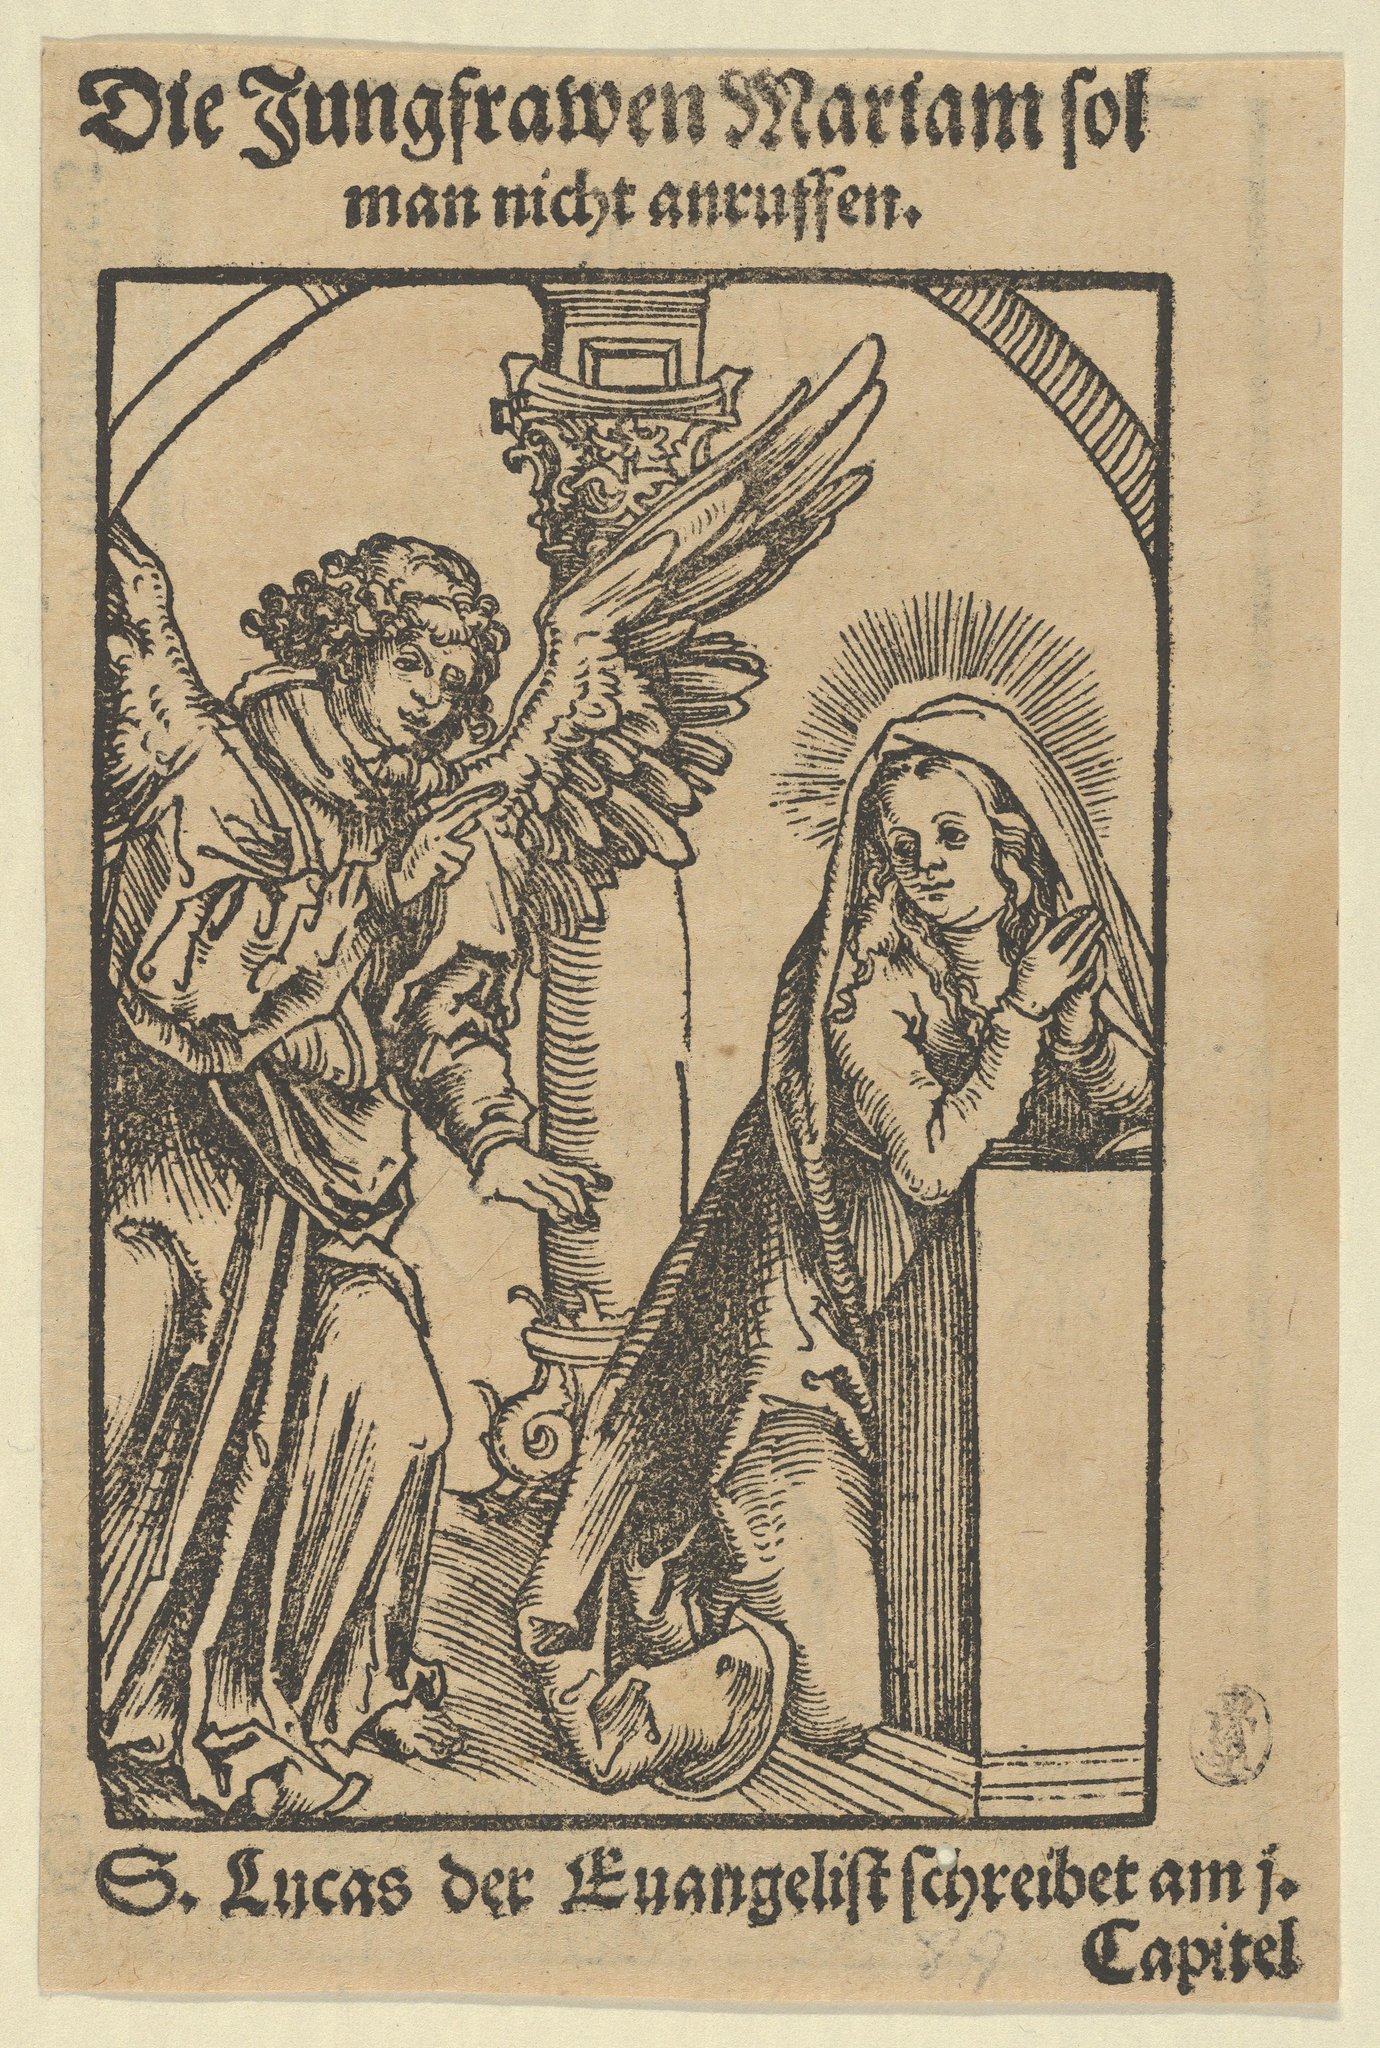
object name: print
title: The Annunciation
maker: lucas cranach the elder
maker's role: artist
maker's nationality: german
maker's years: 1472-1553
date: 1505-1517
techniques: woodcut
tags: angels,virgin mary,annunciation